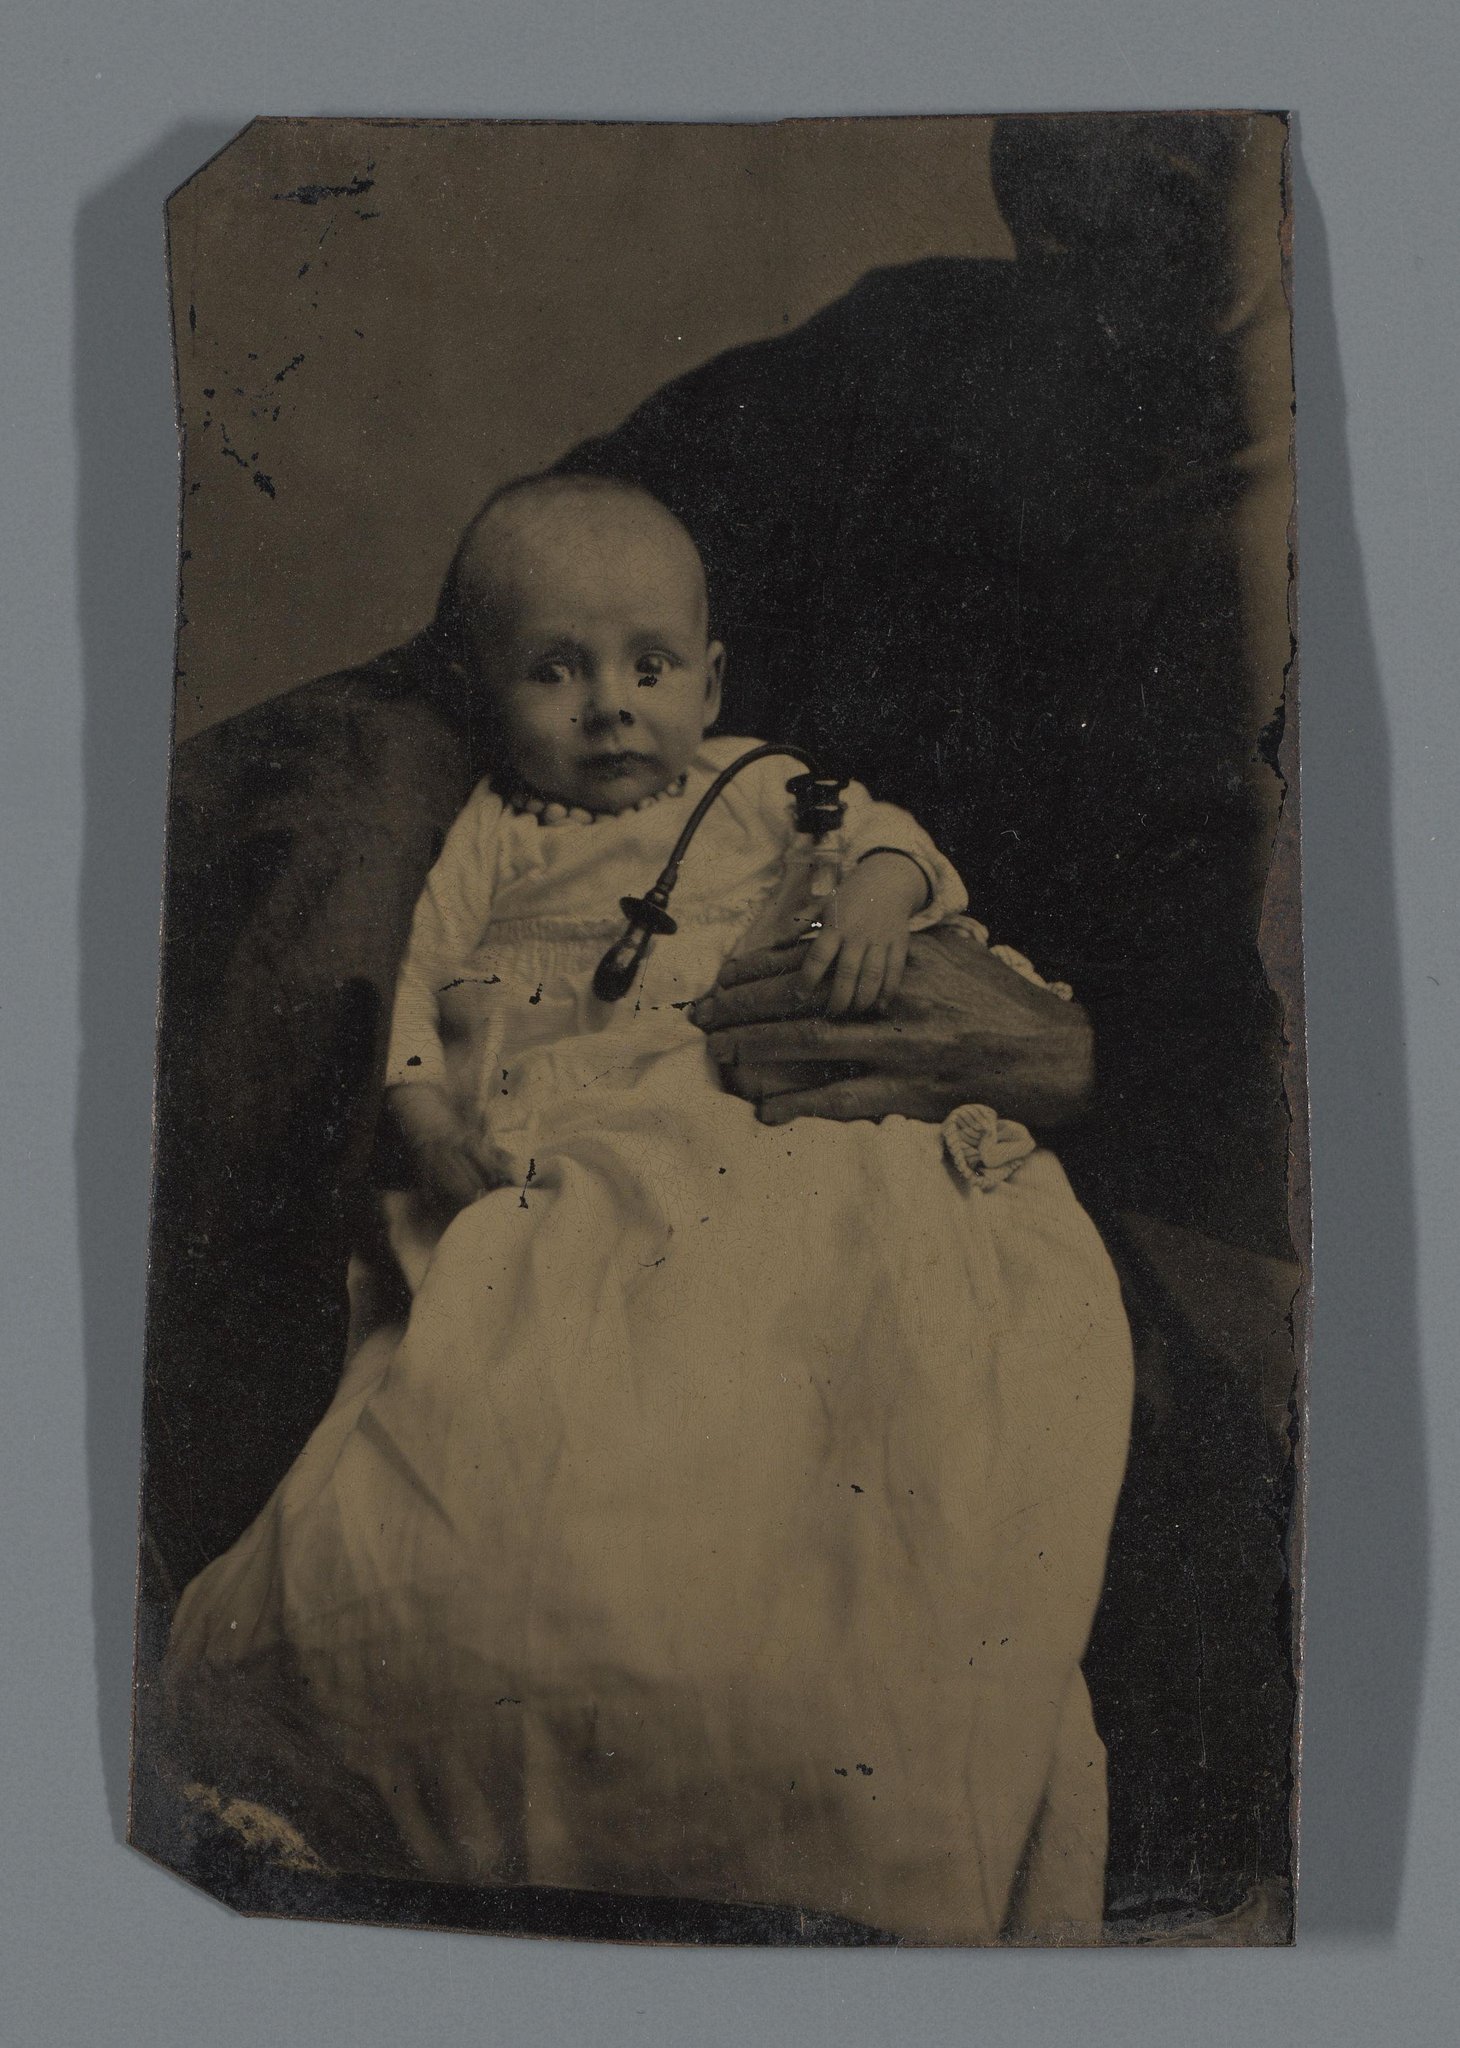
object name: photobook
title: Vrouw met baby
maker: Anonymous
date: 1870-1910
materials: photographic support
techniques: ferrotyping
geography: united states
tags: united states of america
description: Witte baby met speen vastgehouden door twee Zwarte handen.